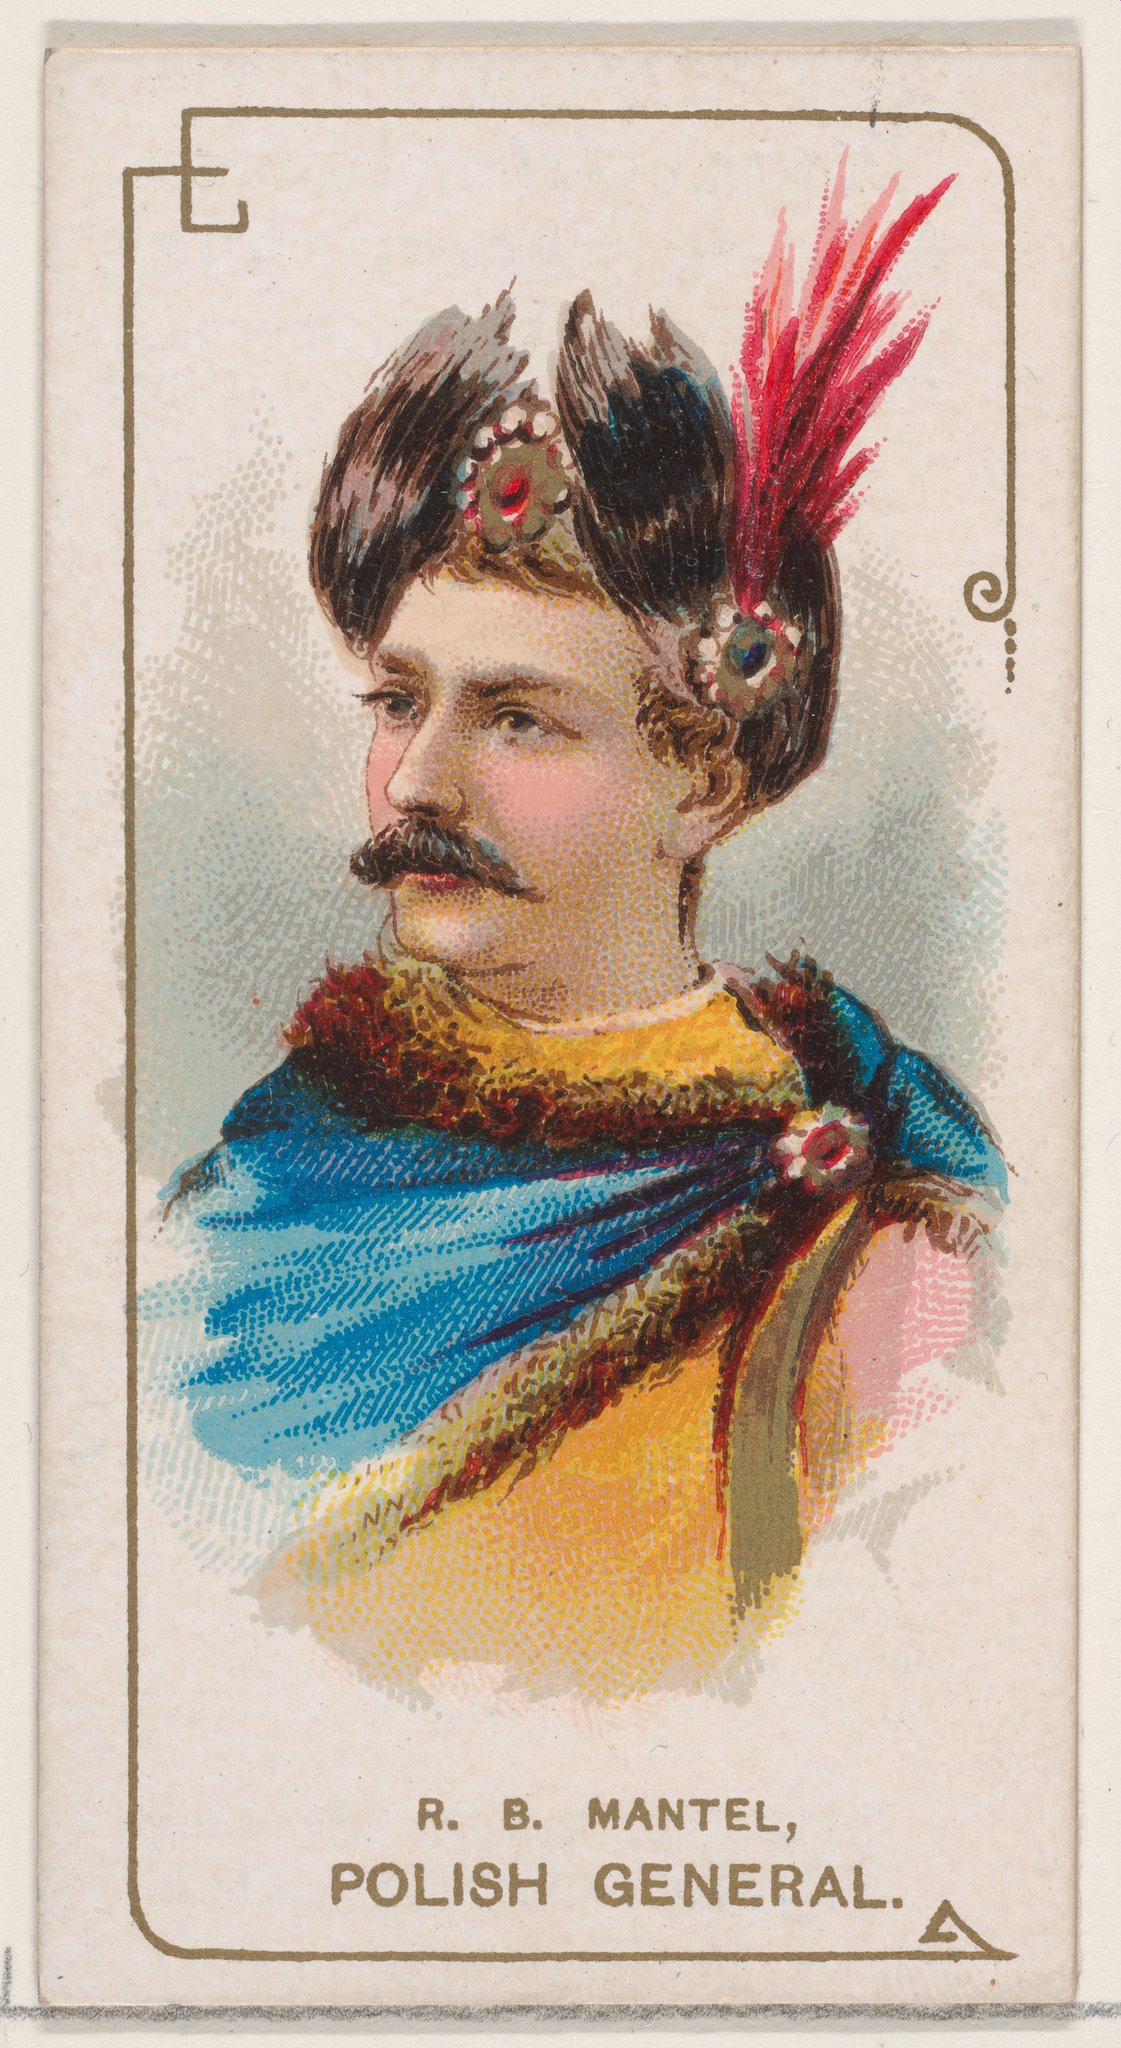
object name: print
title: R. B. Mantel Dressed as Polish General, from the set Actors and Actresses, Second Series (N71) for Duke brand cigarettes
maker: w. duke, sons & co.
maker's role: publisher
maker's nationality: american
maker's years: 1870-1920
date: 1888-1890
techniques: color lithograph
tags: men,actors